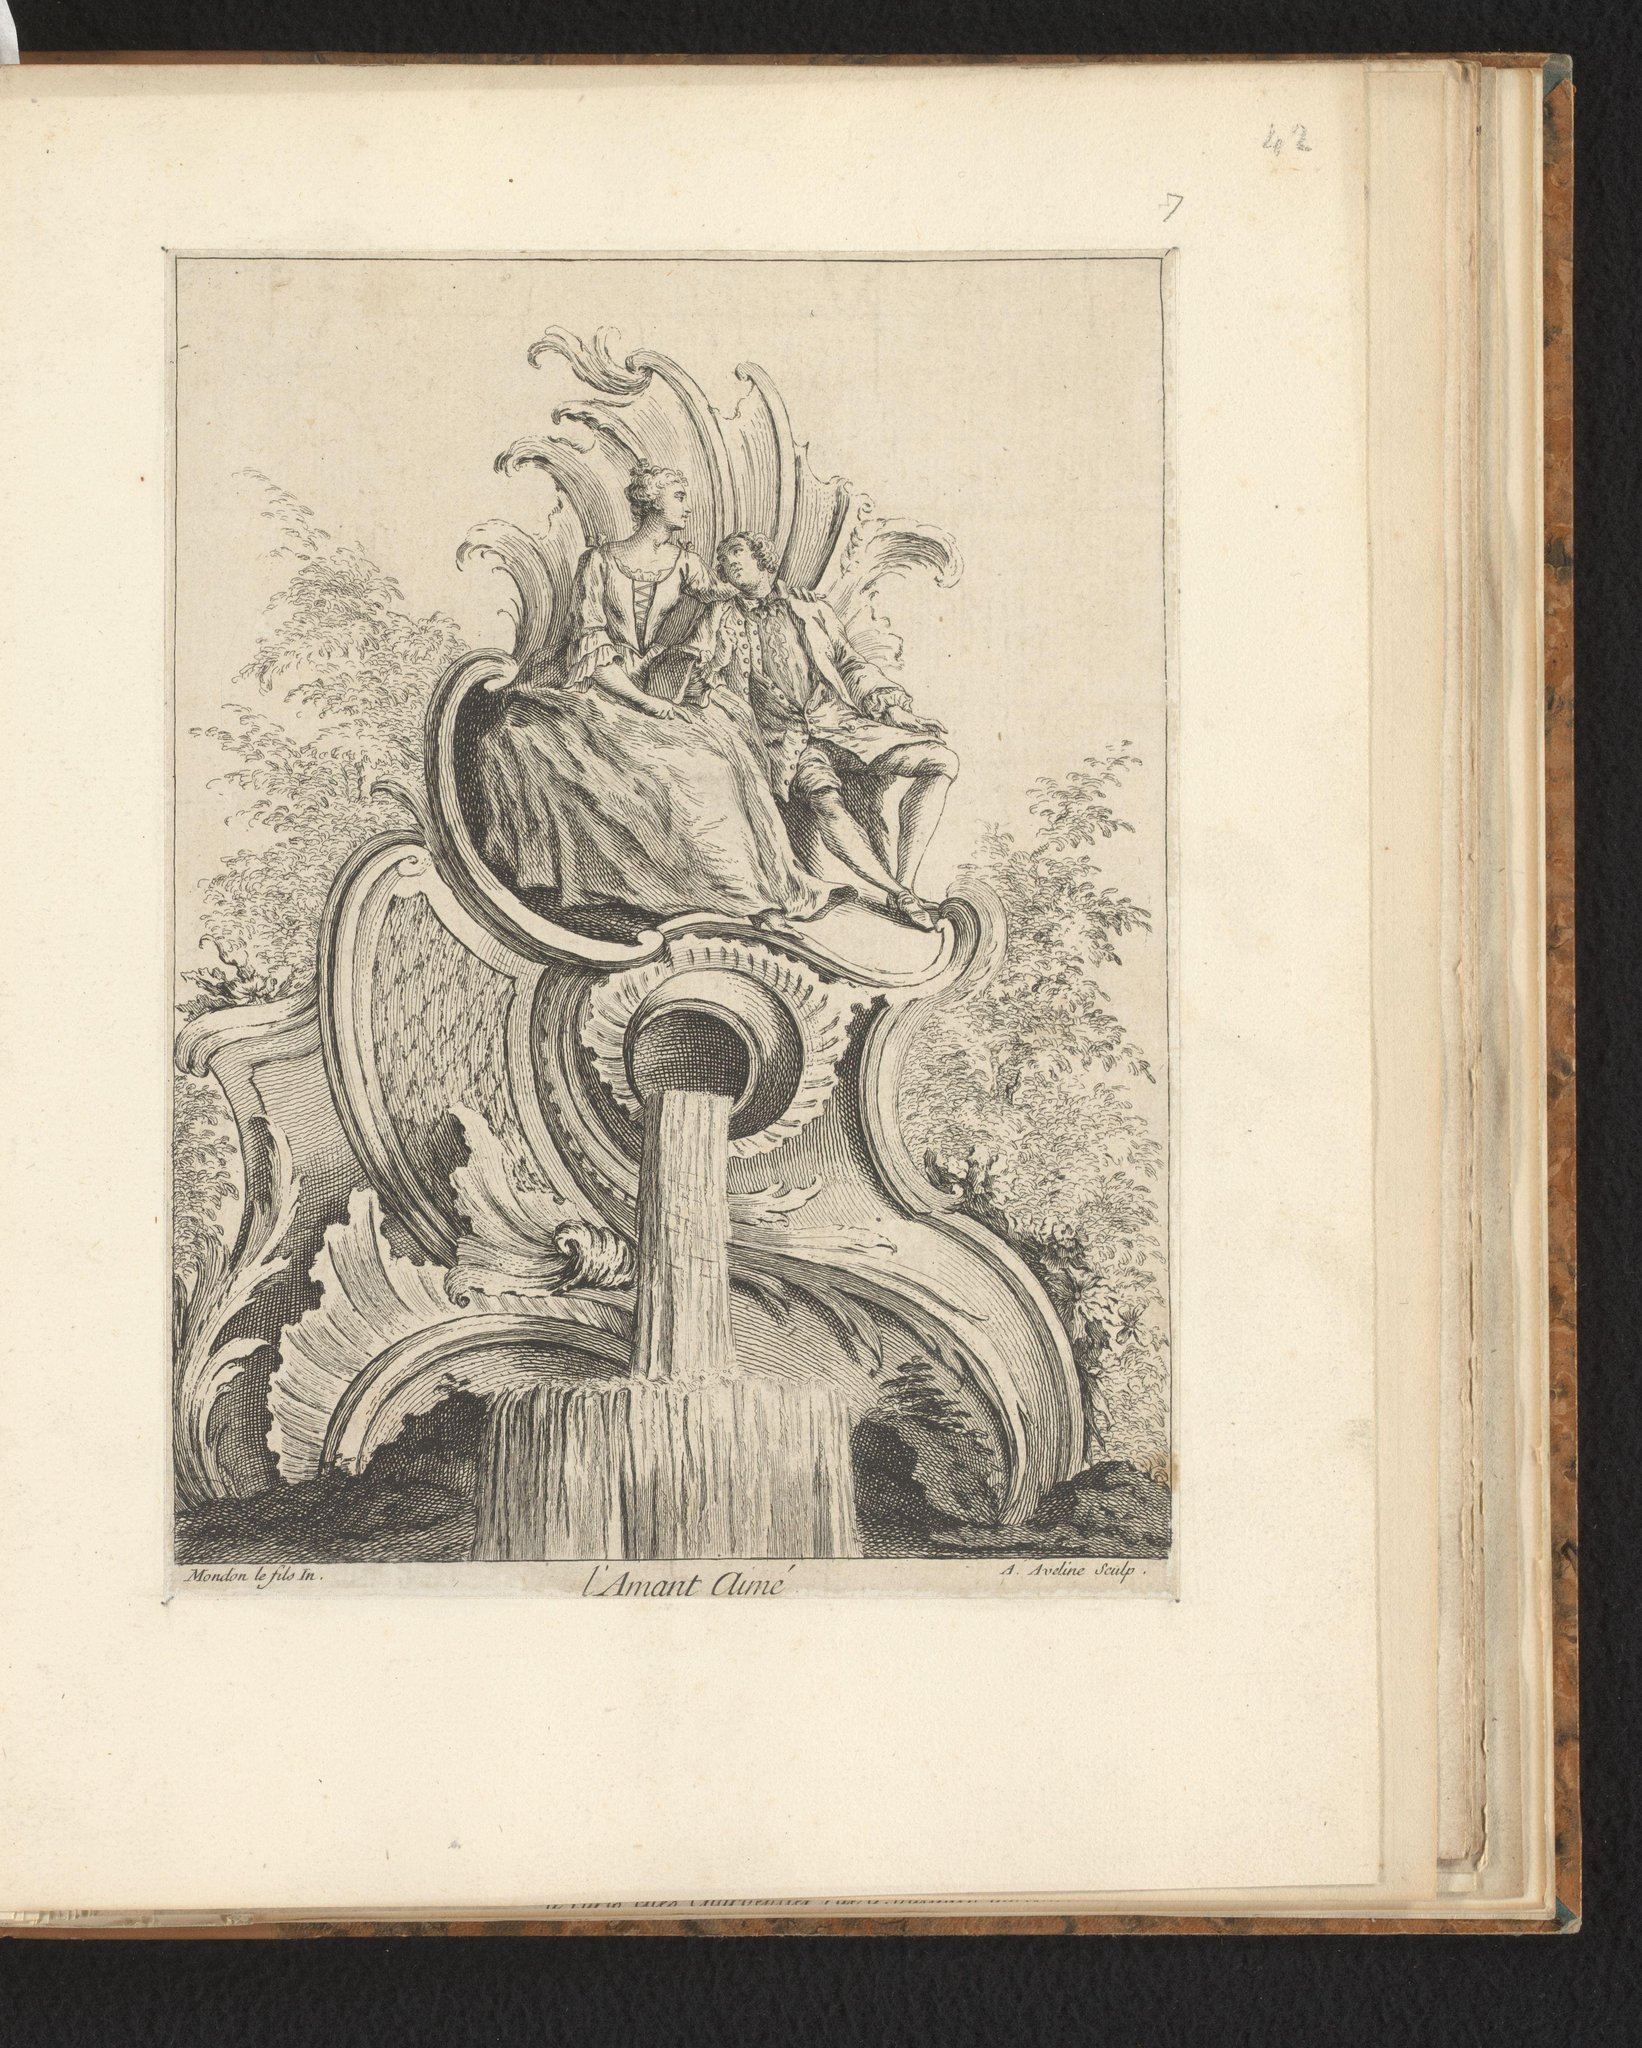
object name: album leaf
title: Sixieme Livre de Formes Rocailles et Cartels ornés de Figures Françoises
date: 1736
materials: paper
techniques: engraving, etching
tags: rocaille ornament, lovers; courting, flirting